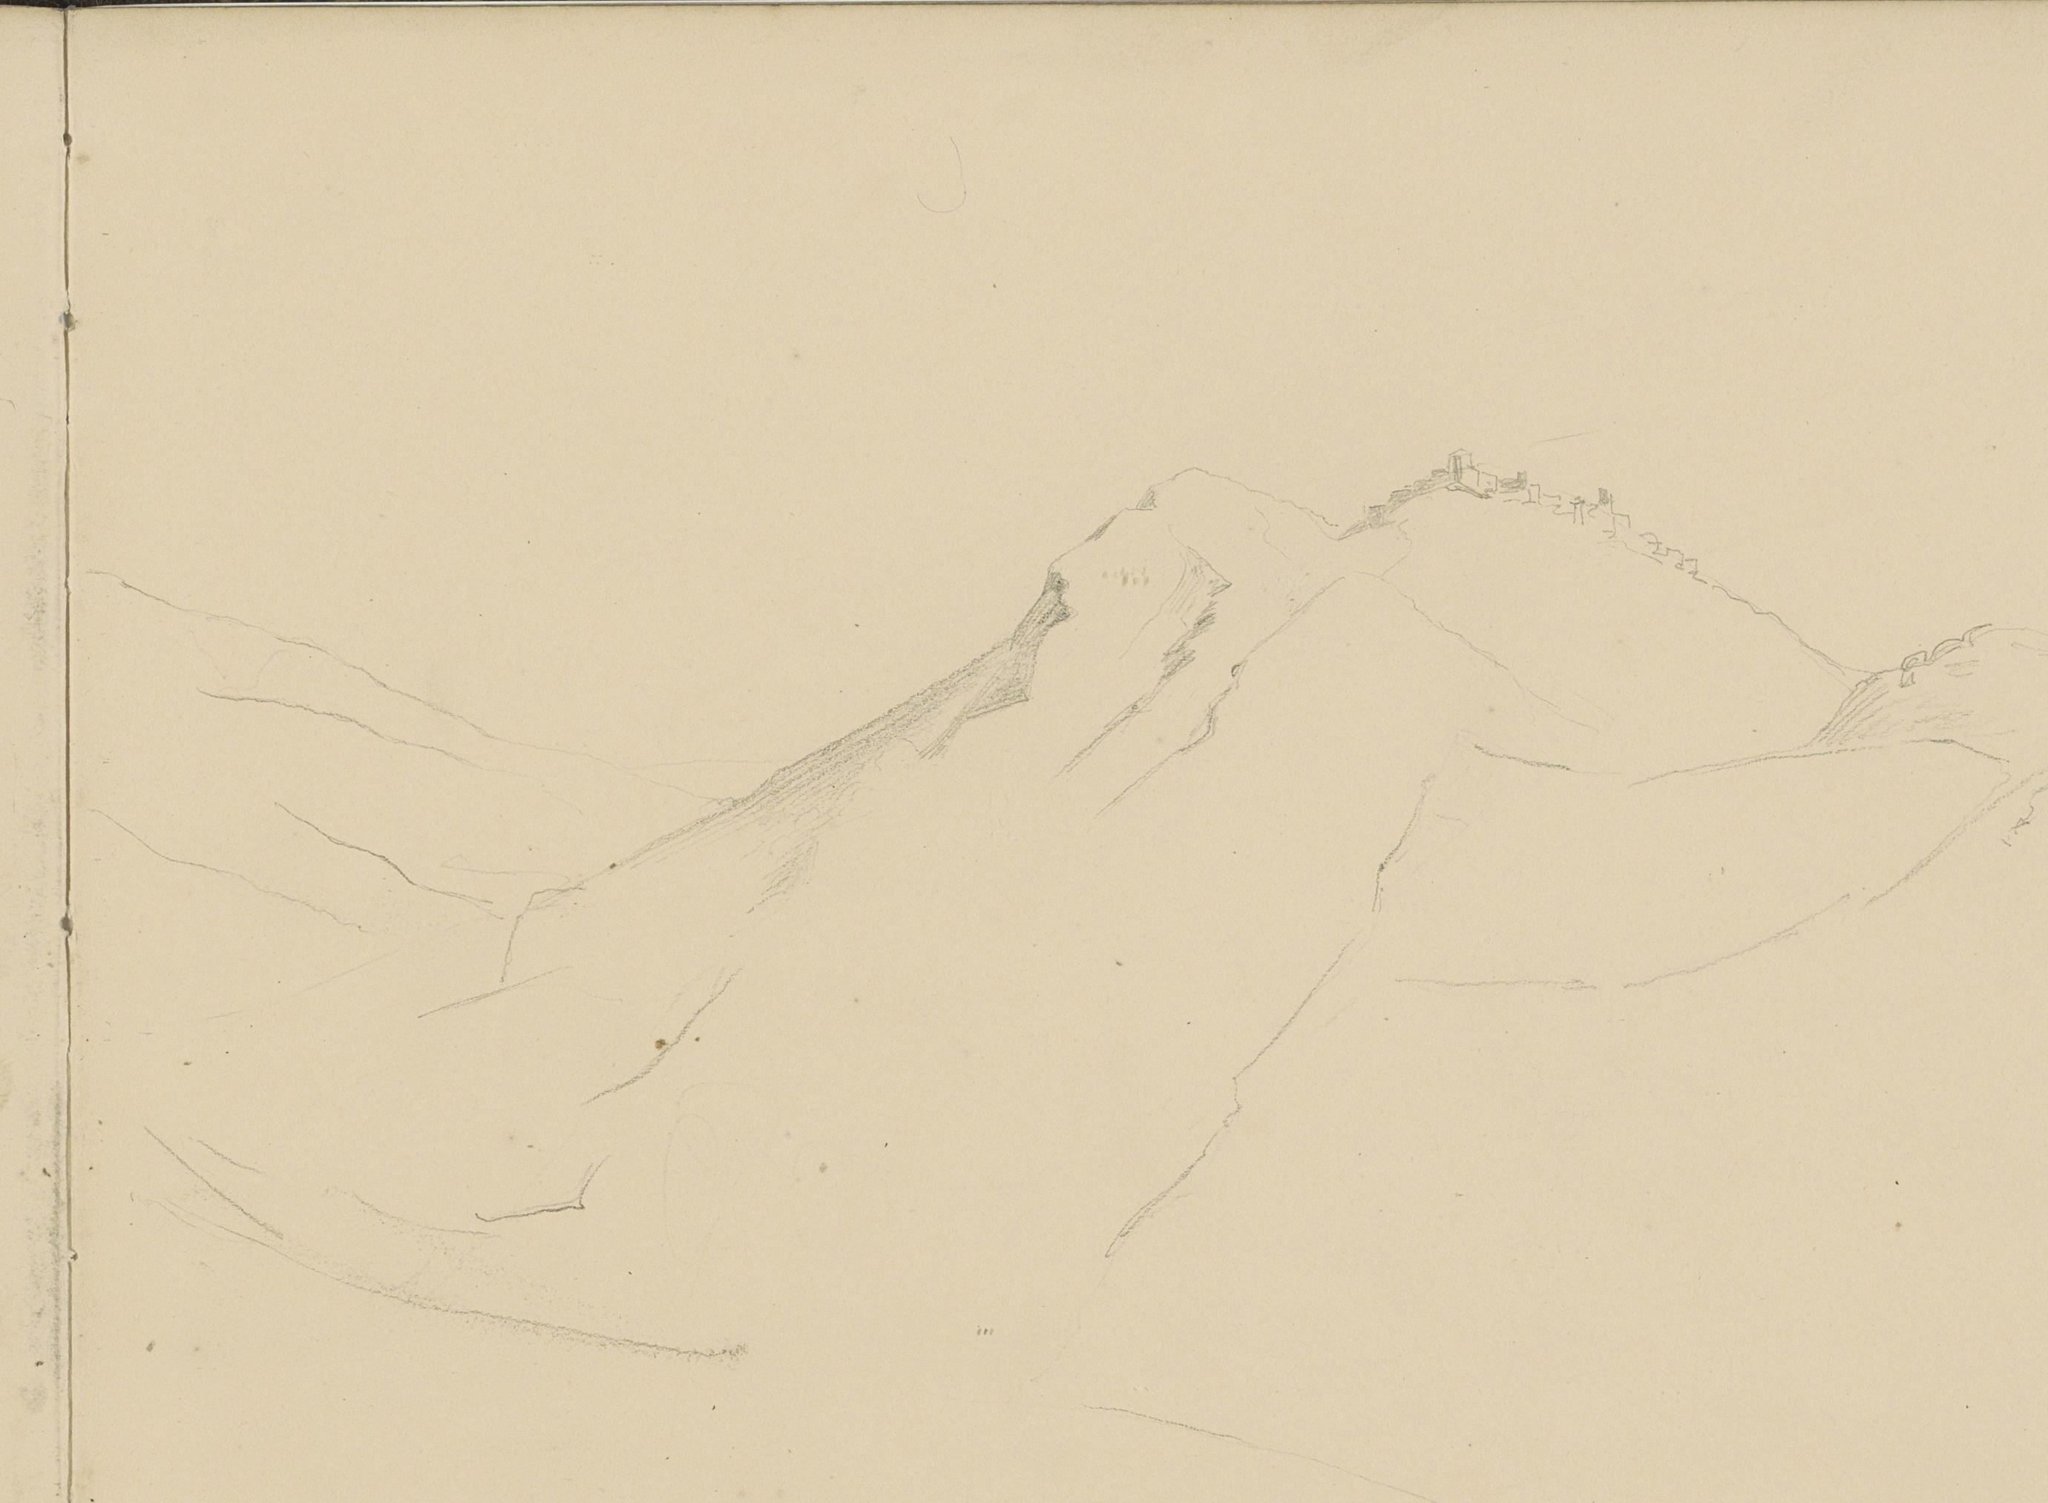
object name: sketchbook leaf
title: Gezicht op Civitella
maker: jacobus everhardus josephus van den berg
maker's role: draughtsman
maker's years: 1802-1861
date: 1804-1830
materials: paper, pencil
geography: civitella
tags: prospect of village, silhouette of village, mountains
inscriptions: date and inscription: ‘civitella April.’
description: Blad 21 recto uit een schetsboek met 26 bladen.